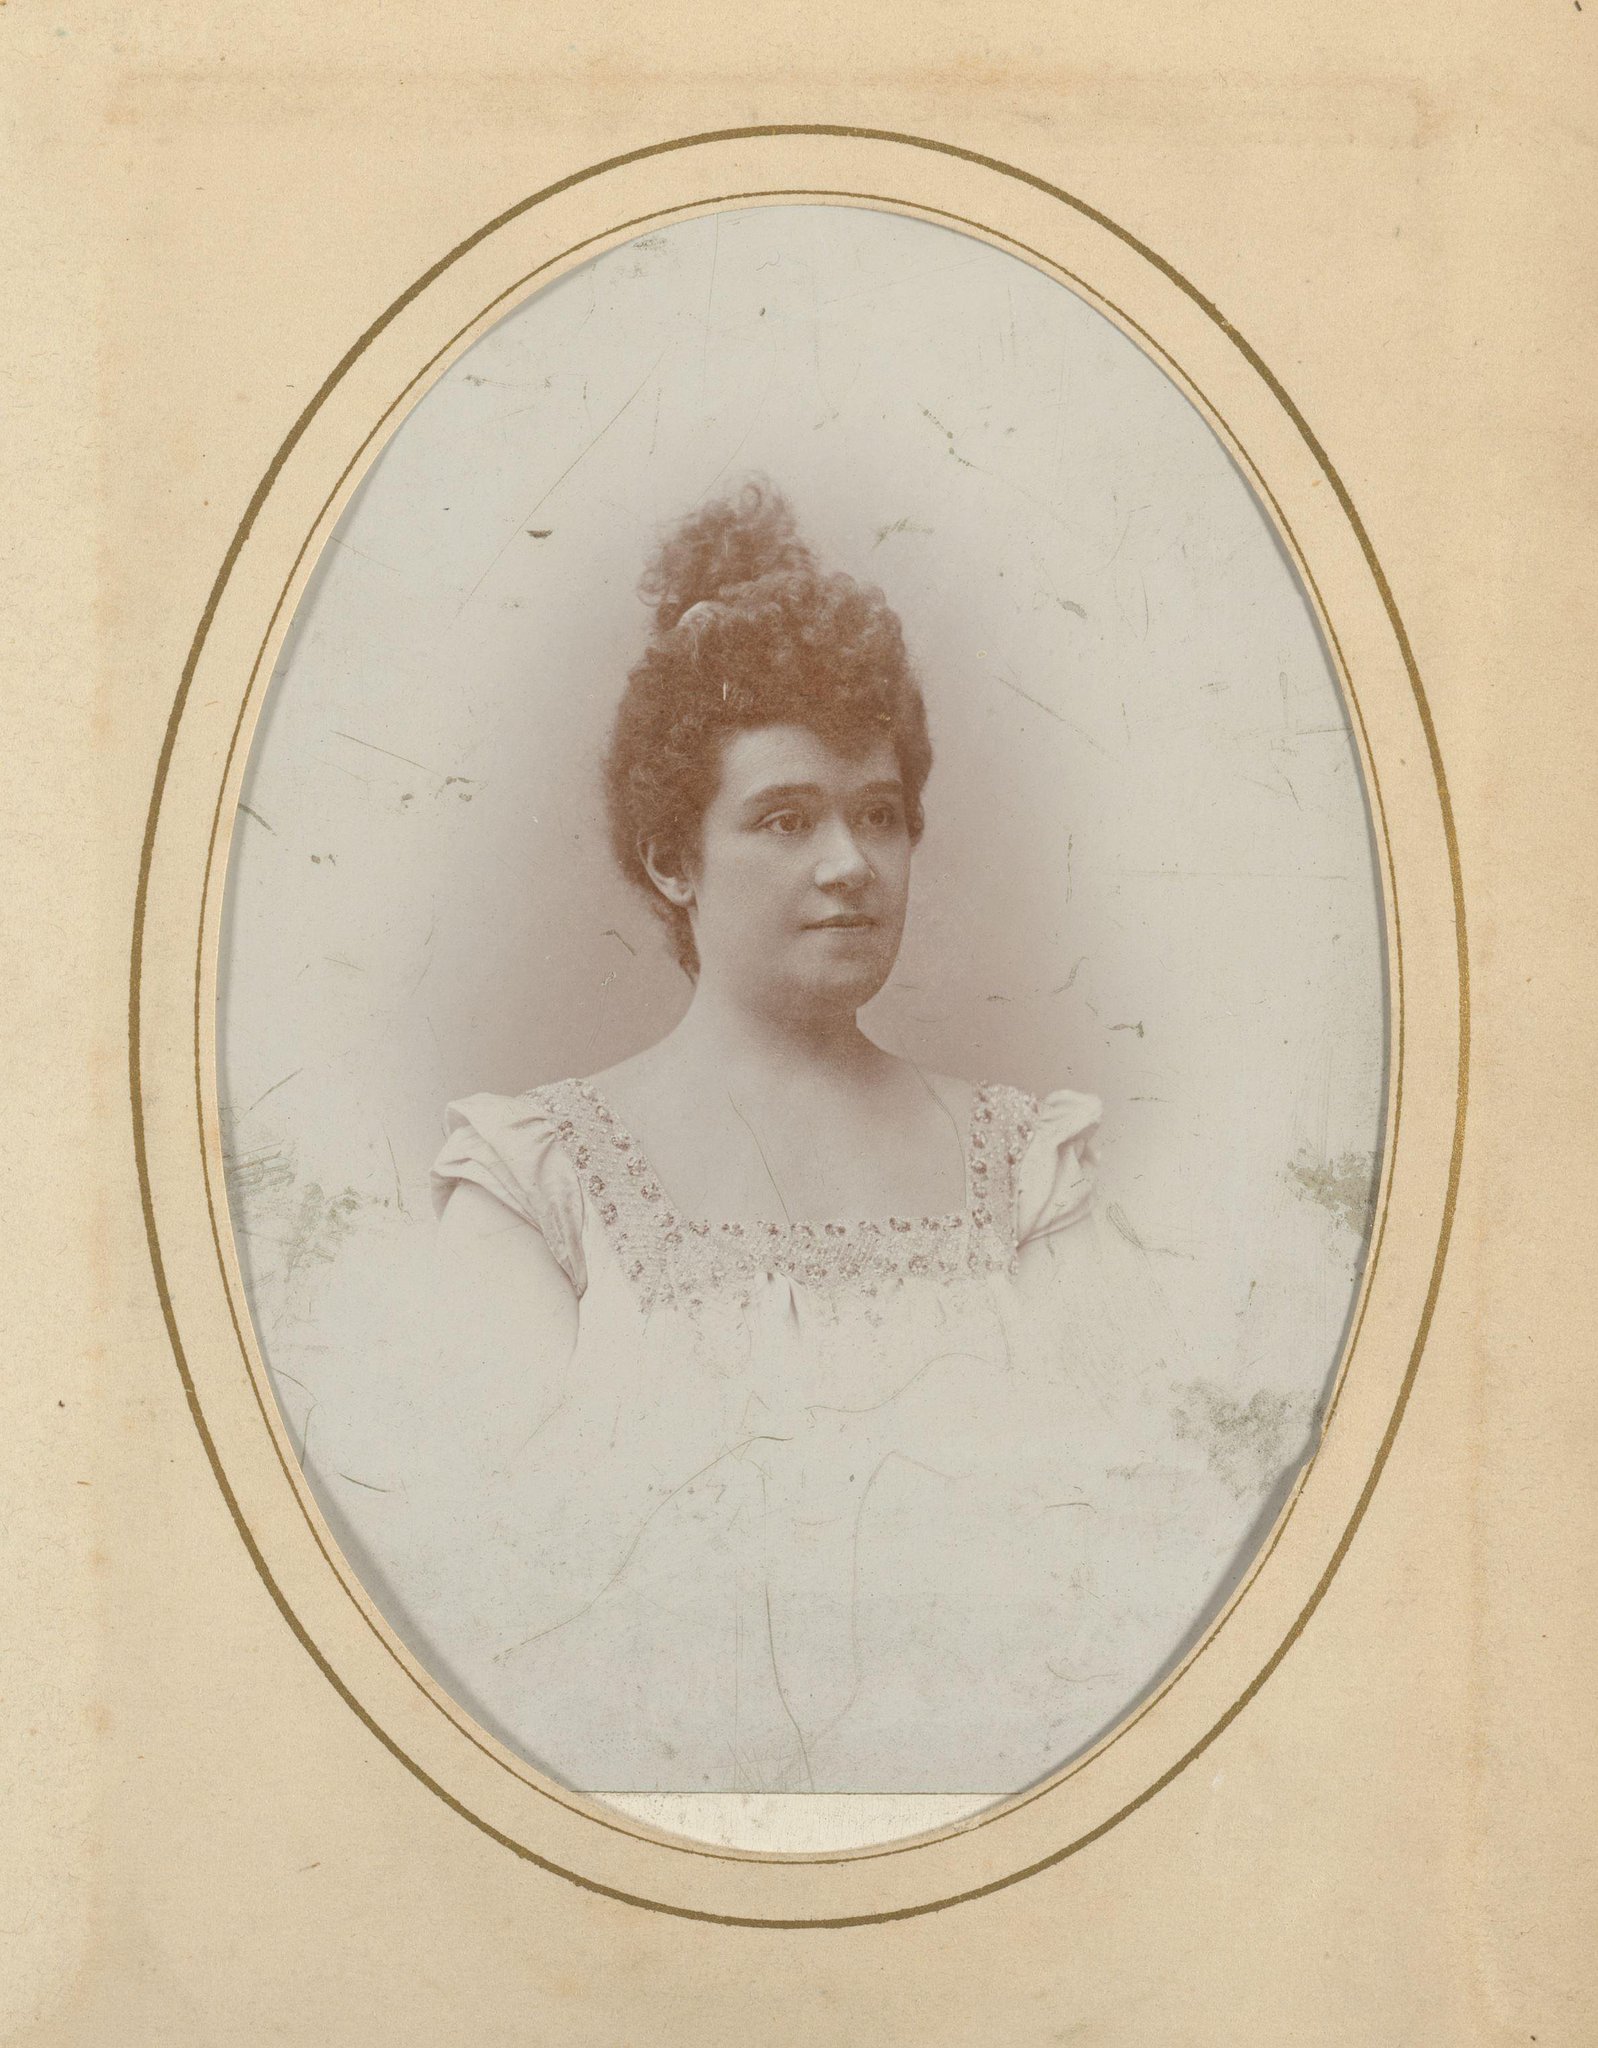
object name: photograph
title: Portret van een vrouw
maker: louis devolder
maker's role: fotograaf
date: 1889-1914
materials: cardboard, photographic support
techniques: collodion silver print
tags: adult man, historical persons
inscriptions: inscription: ‘Photographie/ L. Devolder/ 149/ Rue de Brabant/ Bruxelles/ (...)’